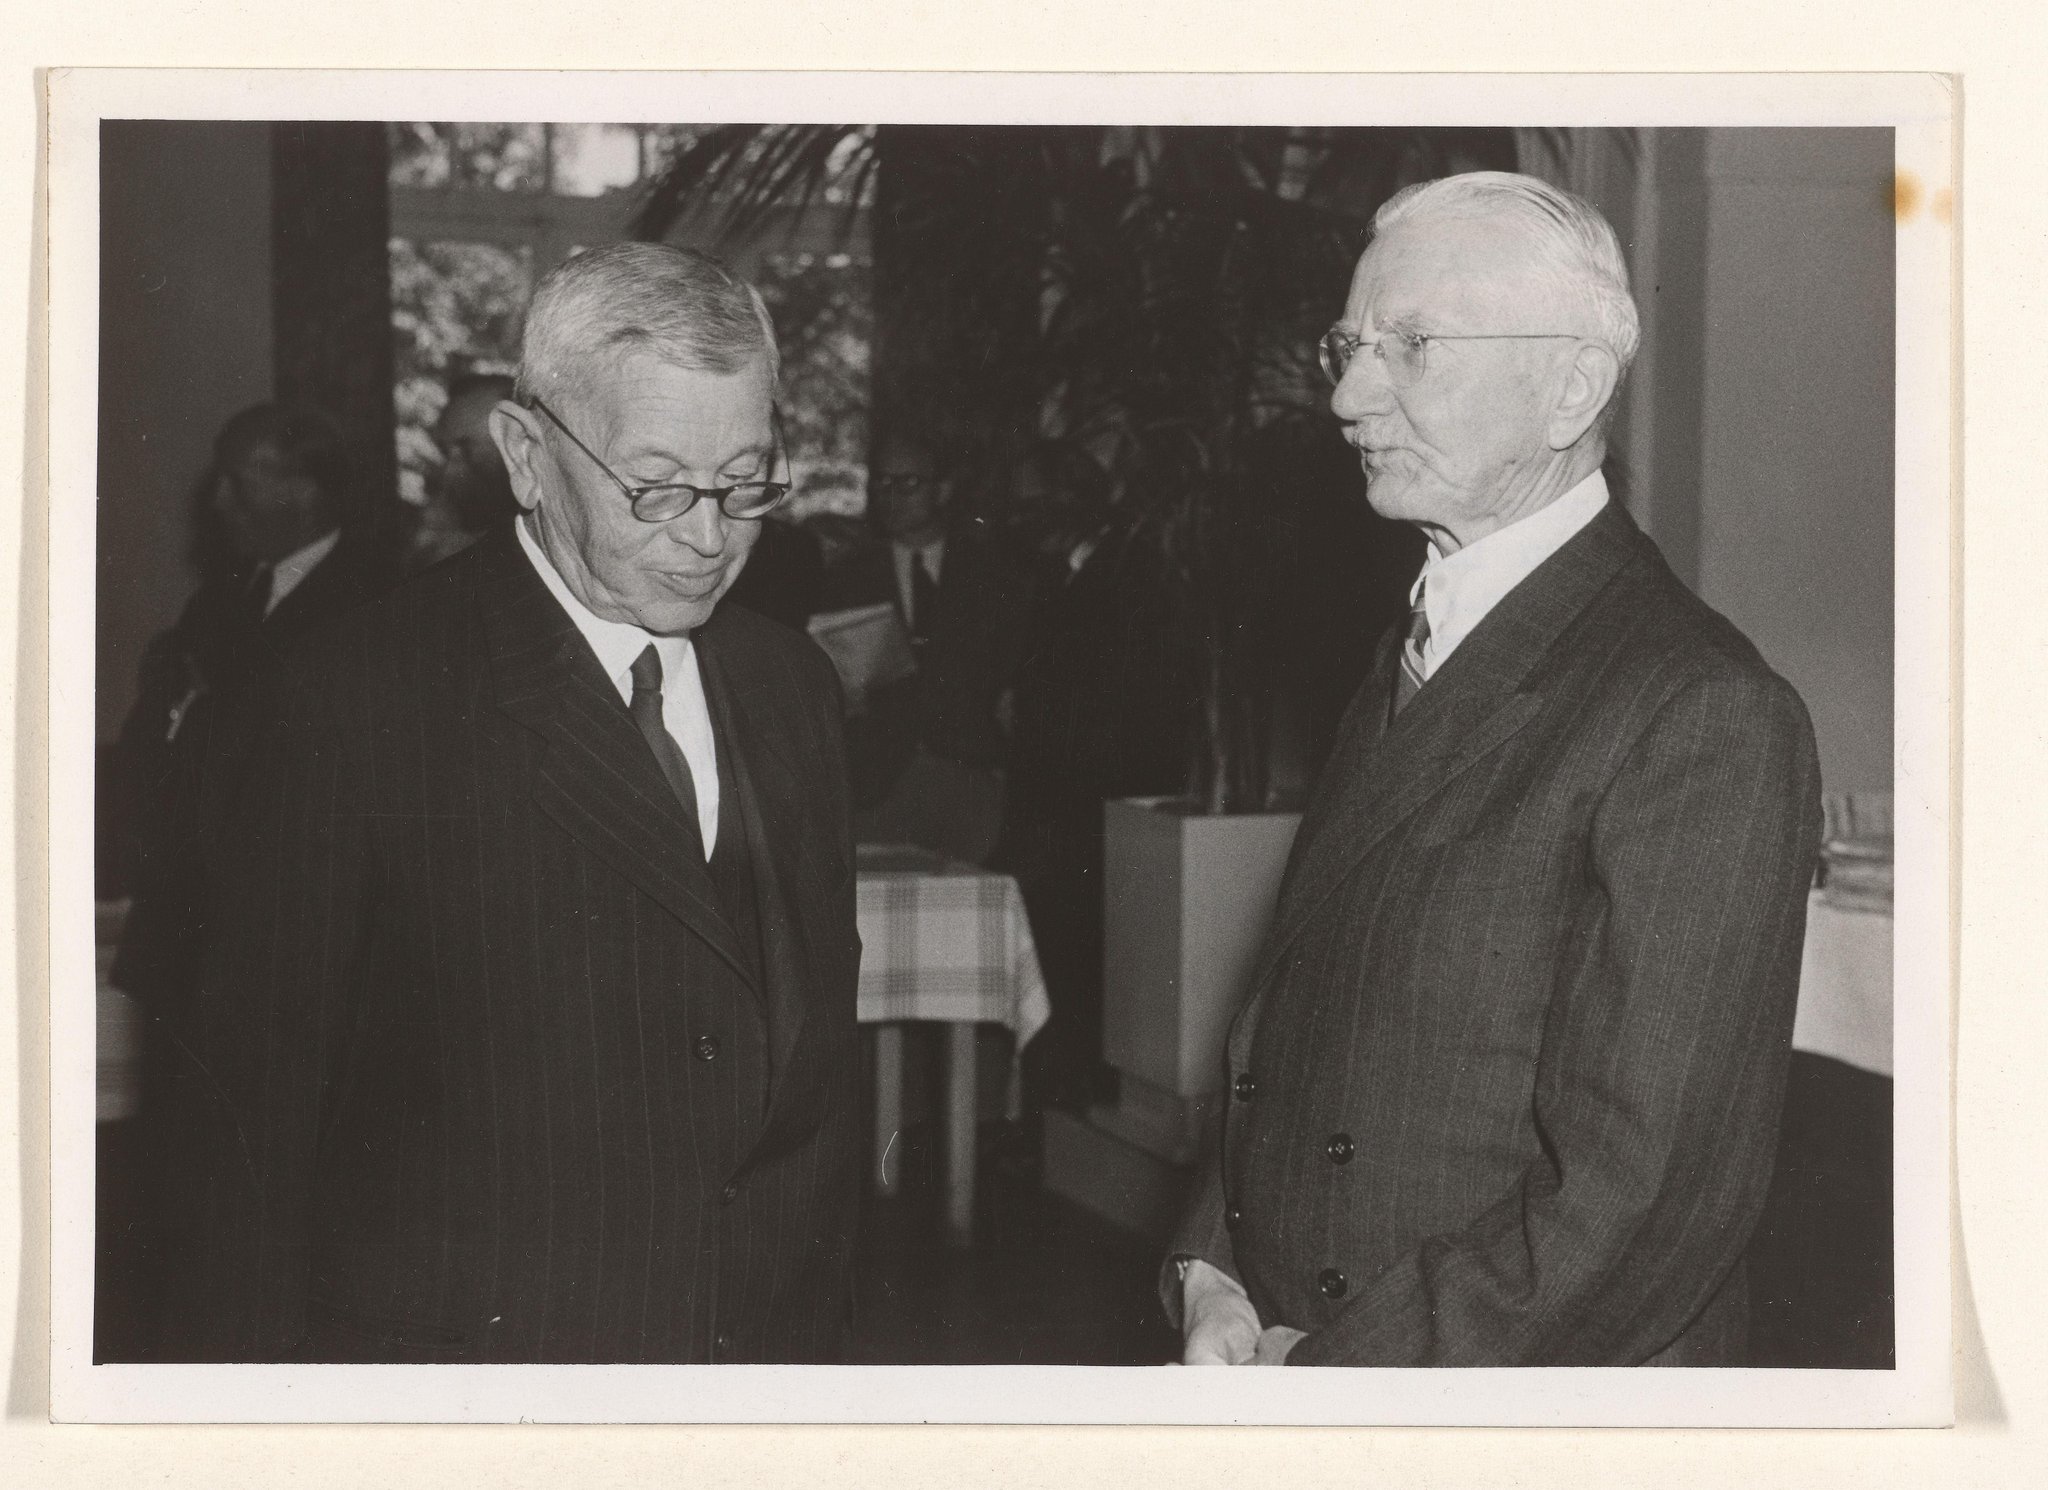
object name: photograph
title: Dr. Hjalmar Schacht tijdens het denazificatieproces in 1950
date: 1908-1950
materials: photographic support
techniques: gelatin silver print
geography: new york city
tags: münchen, econoom, hjalmar horace greeley schacht